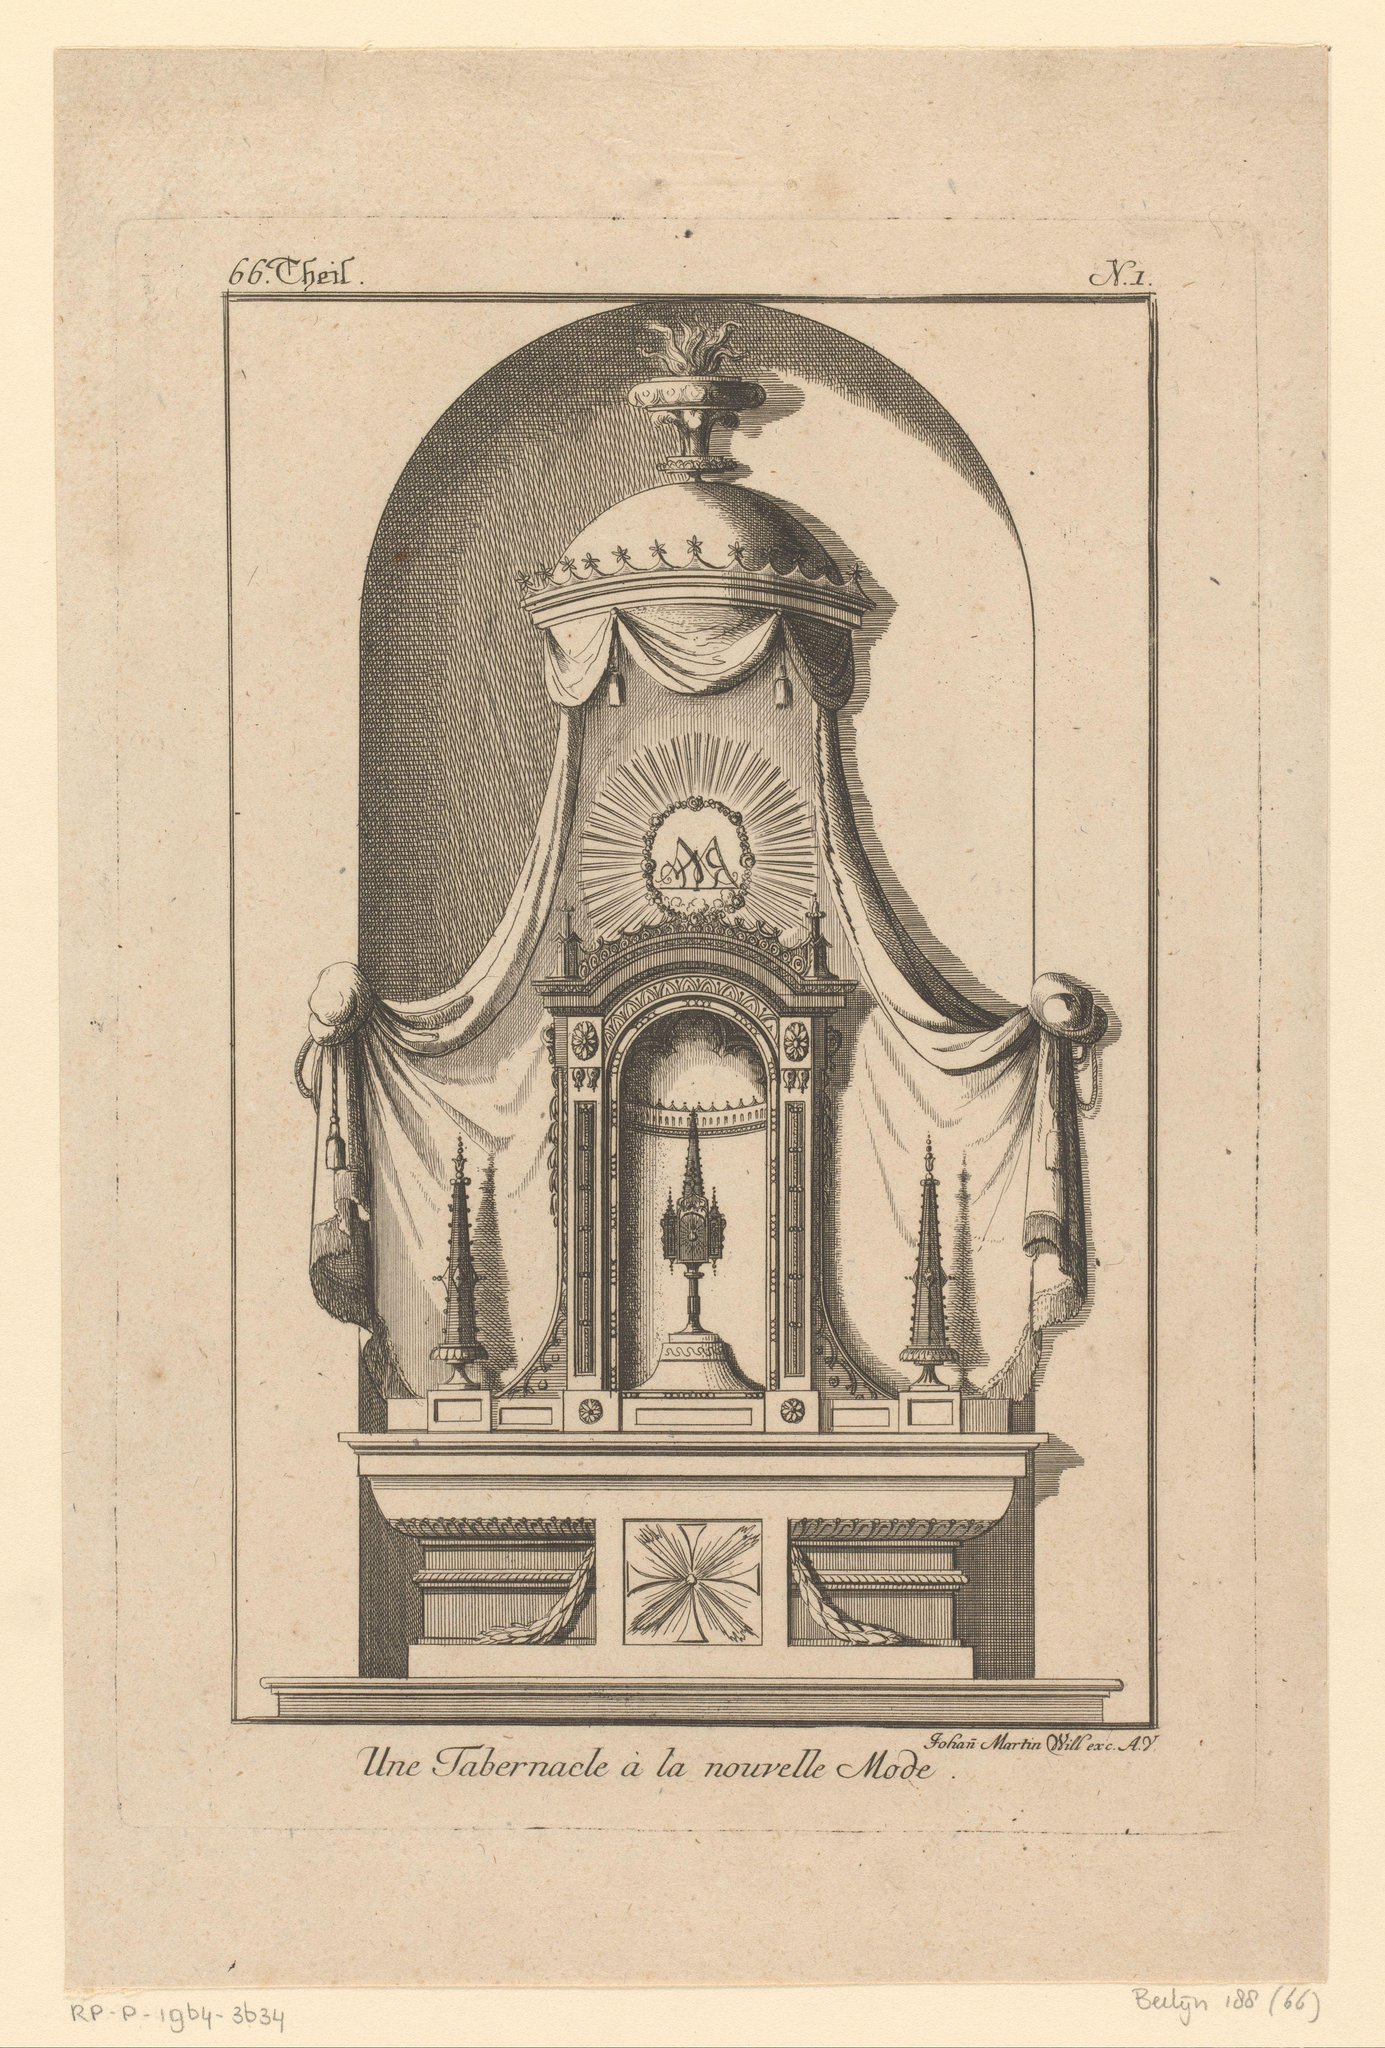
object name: print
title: Tabernakel met baldakijn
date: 1737-1806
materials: paper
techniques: engraving, etching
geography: augsburg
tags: canopy, baldachin, vessels and utensils used in the church, tabernacle ~ altar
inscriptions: collector's mark: Lugt 2228, collector's mark: Lugt 2760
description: Een tabernakel met liturgisch vaatwerk onder een baldakijn met een vaas.